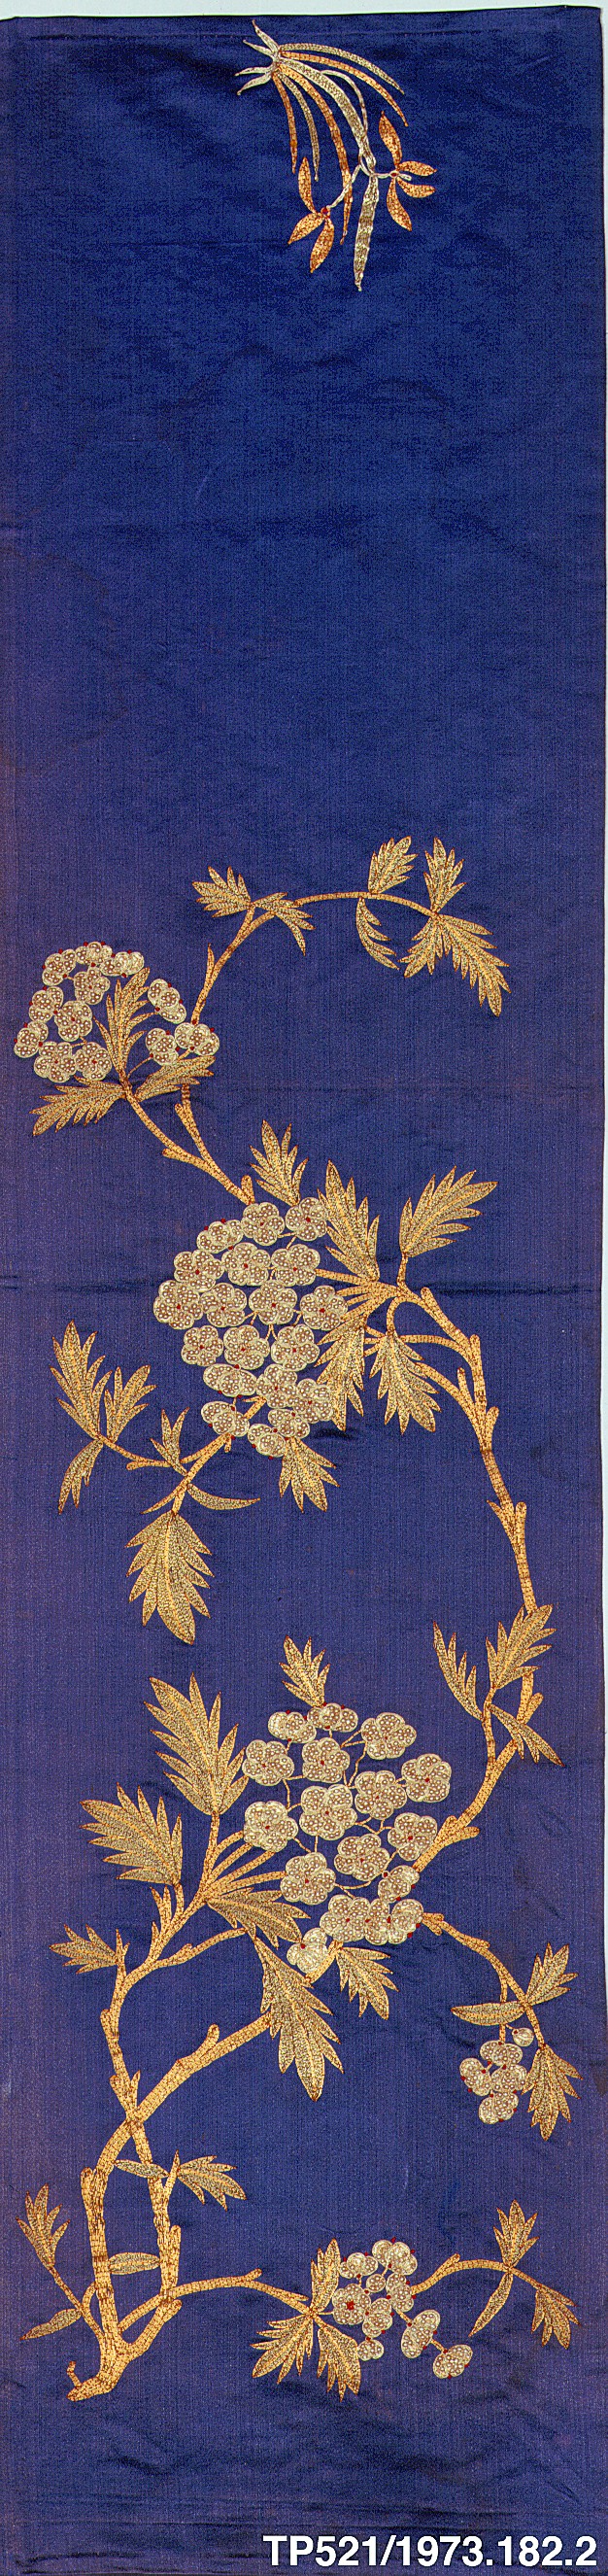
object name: sleeve band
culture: chinese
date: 1801-1900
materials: glass, metal thread, pearl, silk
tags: flowers,leaves